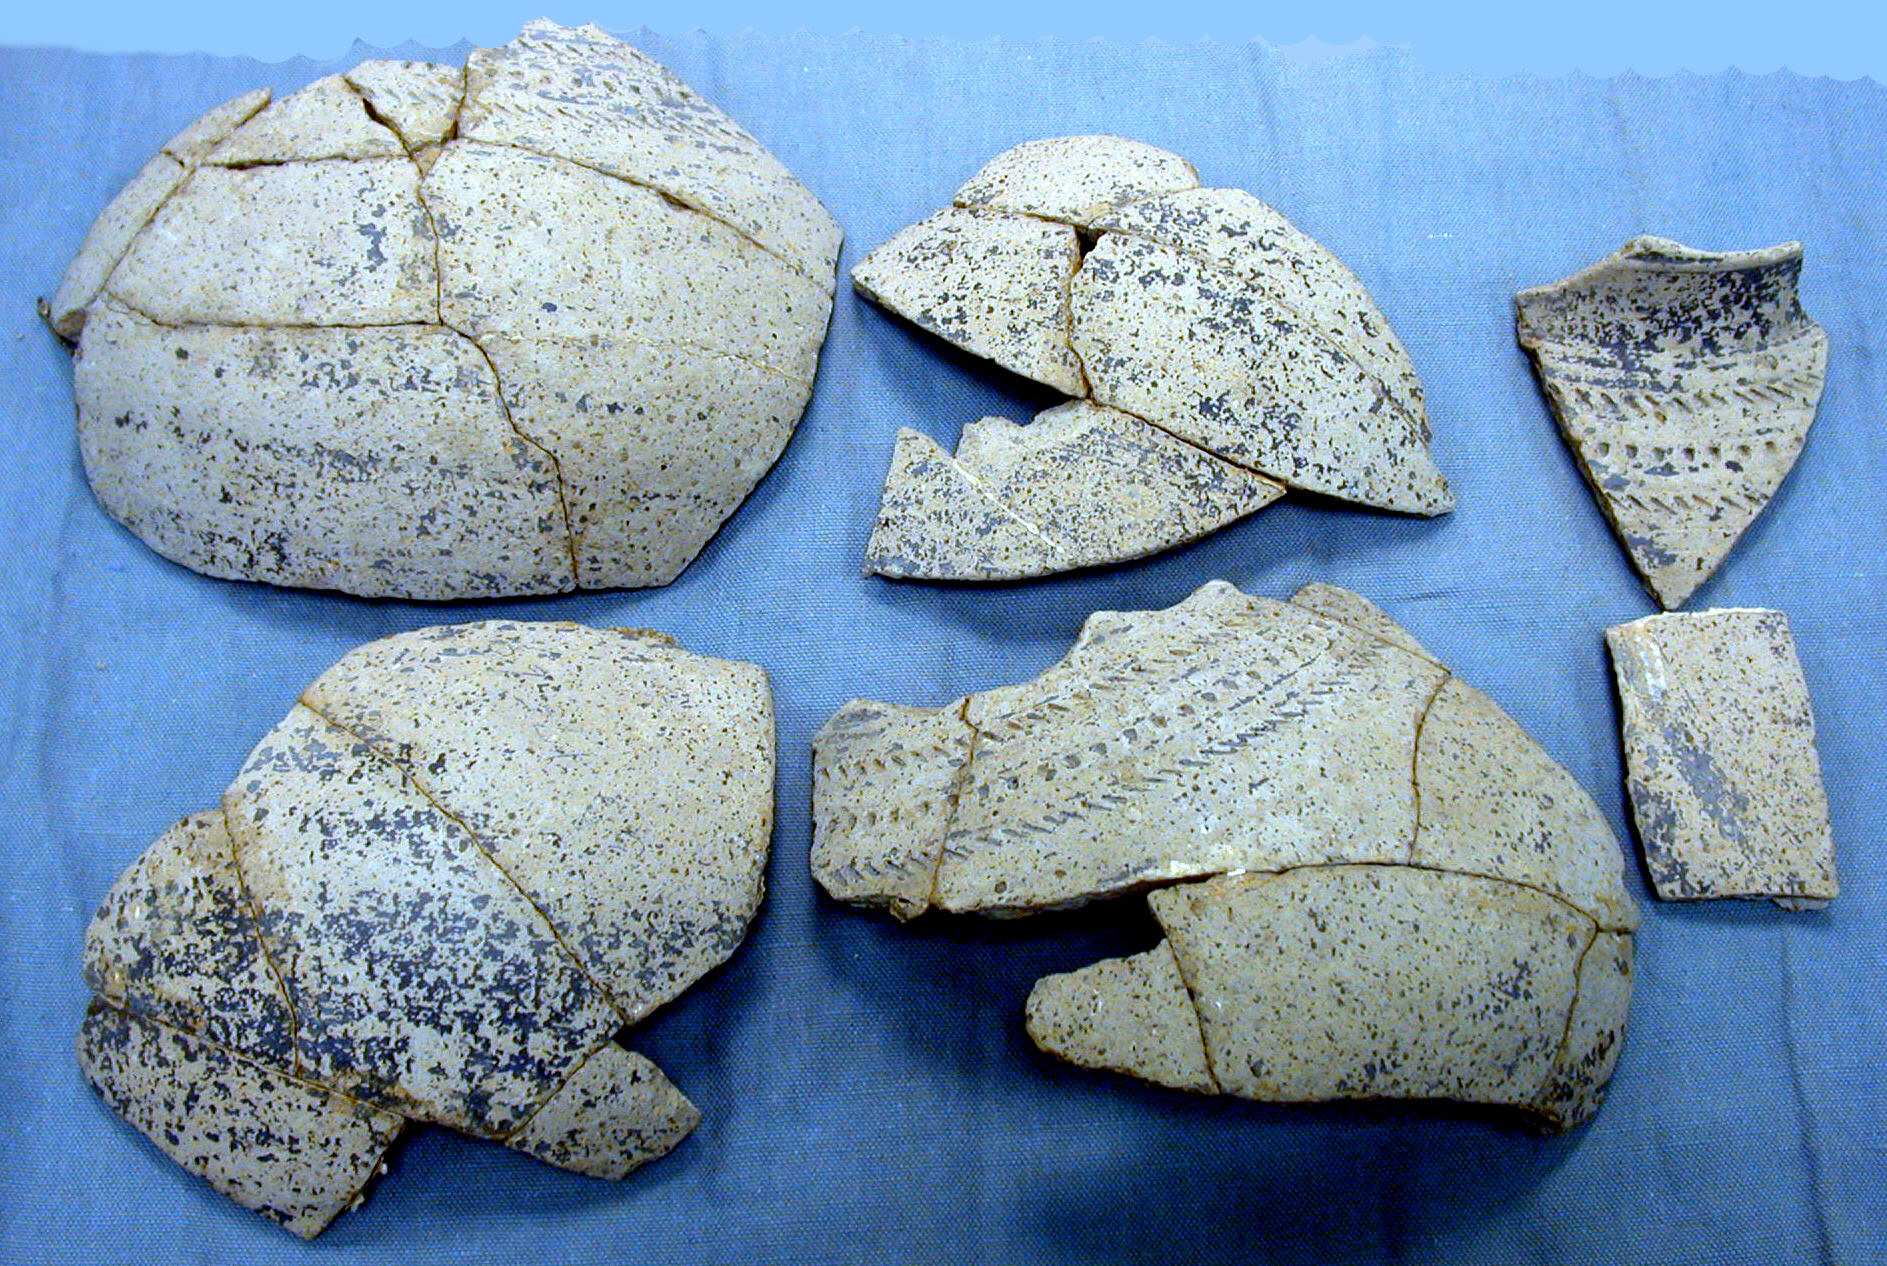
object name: jug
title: Jug sherds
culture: sasanian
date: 201-700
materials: ceramic, glaze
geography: iran